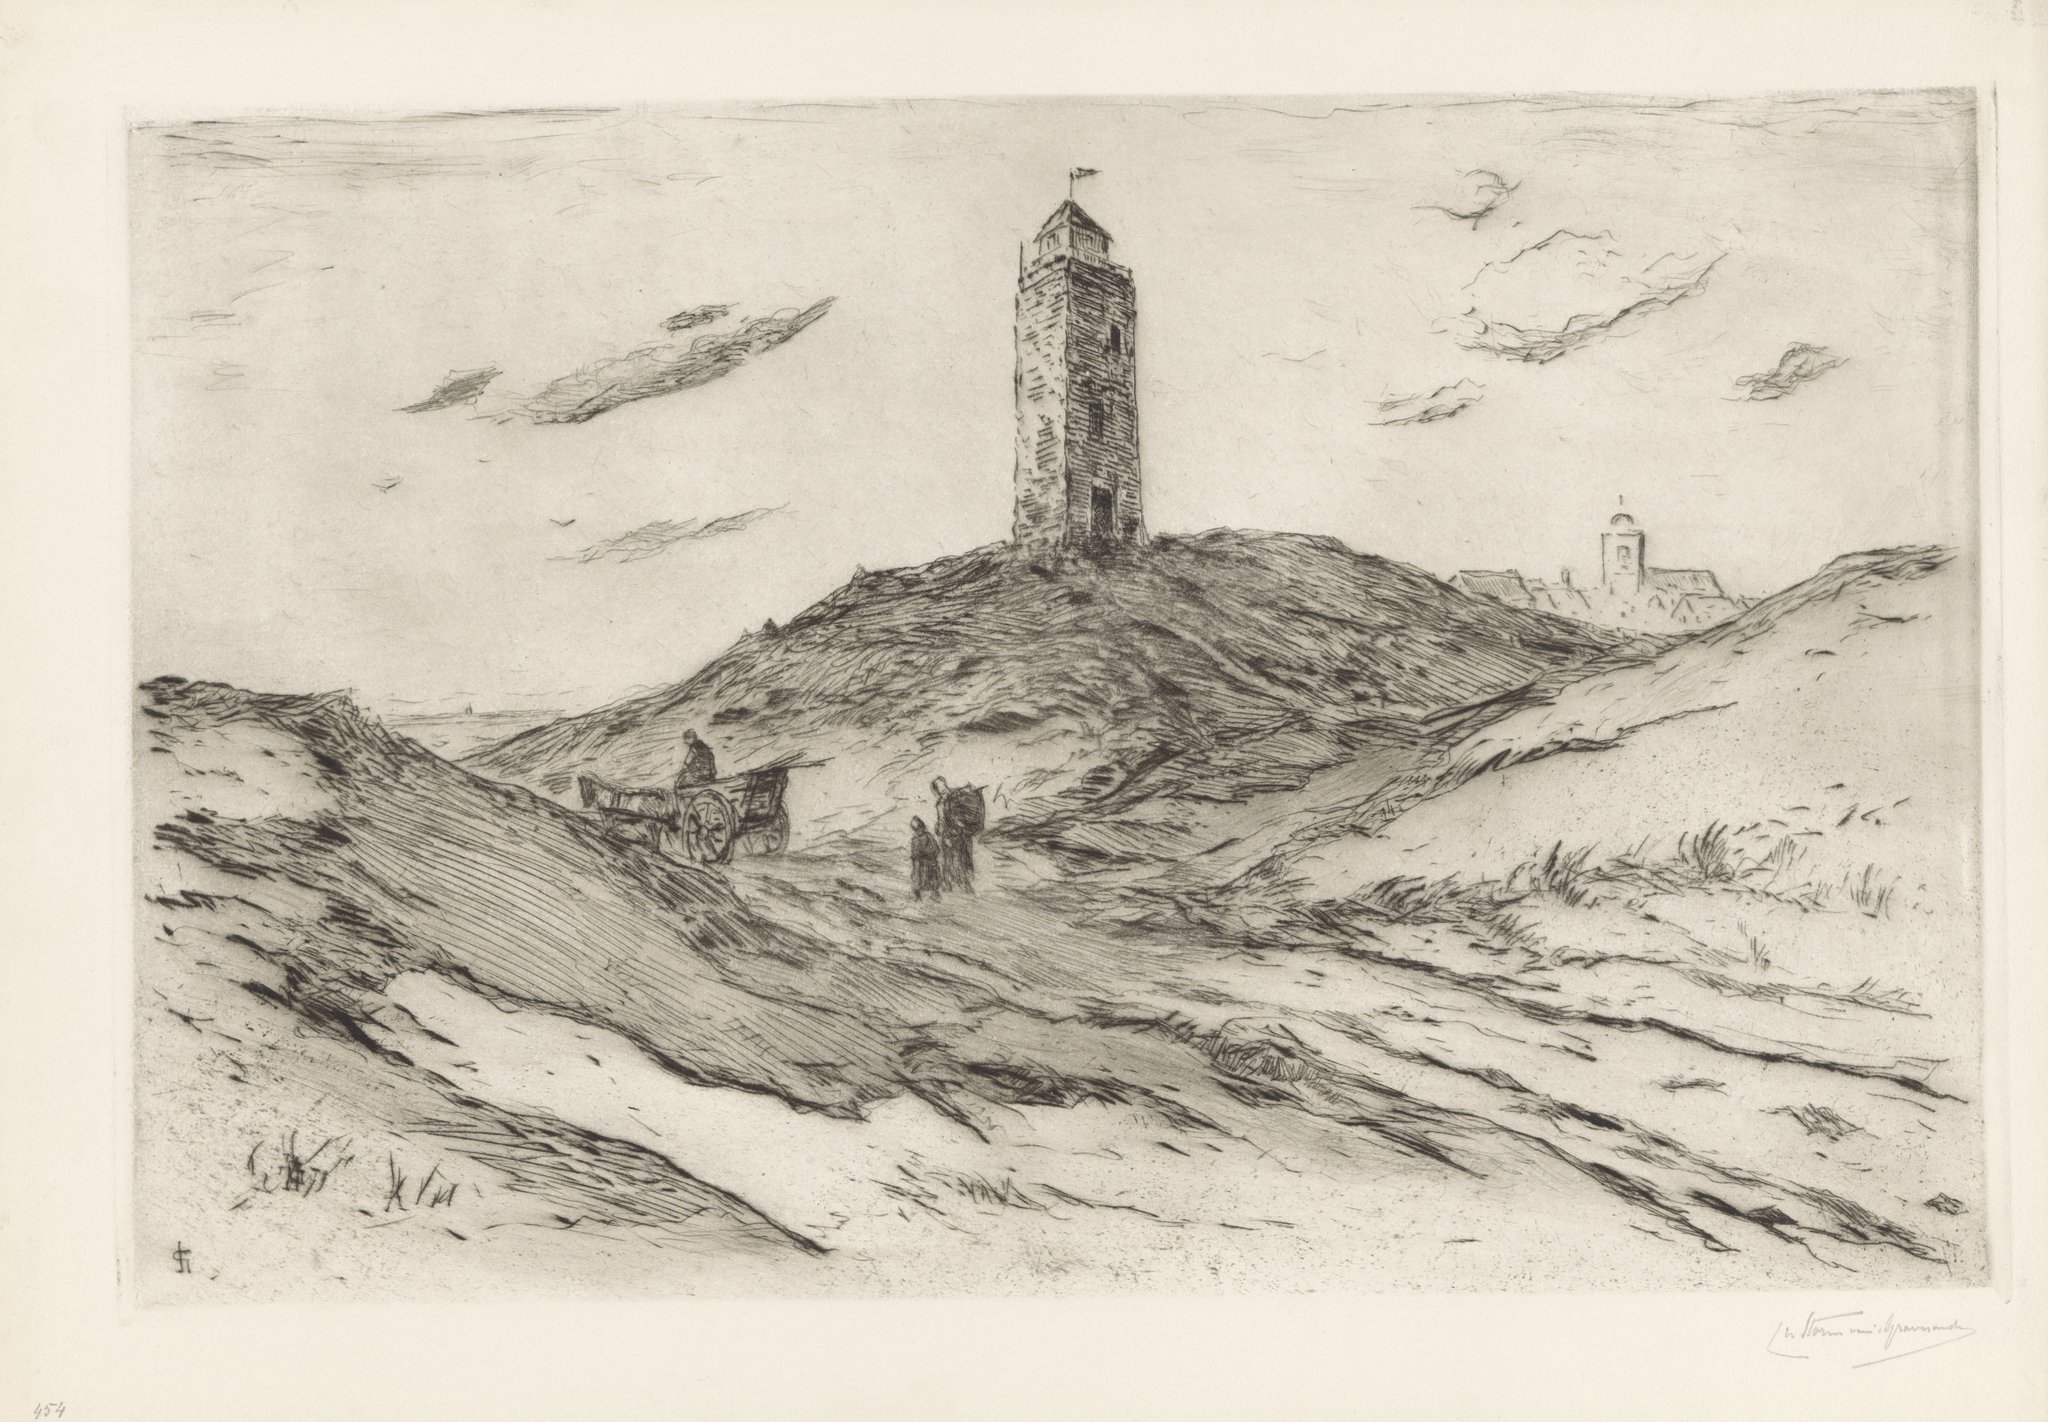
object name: print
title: Vuurtoren te Katwijk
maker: carel nicolaas storm van s-gravesande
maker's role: draughtsman, print maker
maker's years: 1841-1924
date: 1869-1902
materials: paper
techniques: drypoint, etching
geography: netherlands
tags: lighthouse, lightship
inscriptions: collector's mark: Lugt 2228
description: Op het duin staat de vuurtoren van Katwijk. Rechts tussen twee duinen een gezicht op het dorp. Op een pad een man op een paardenkar en daarachter een vrouw en een kind.